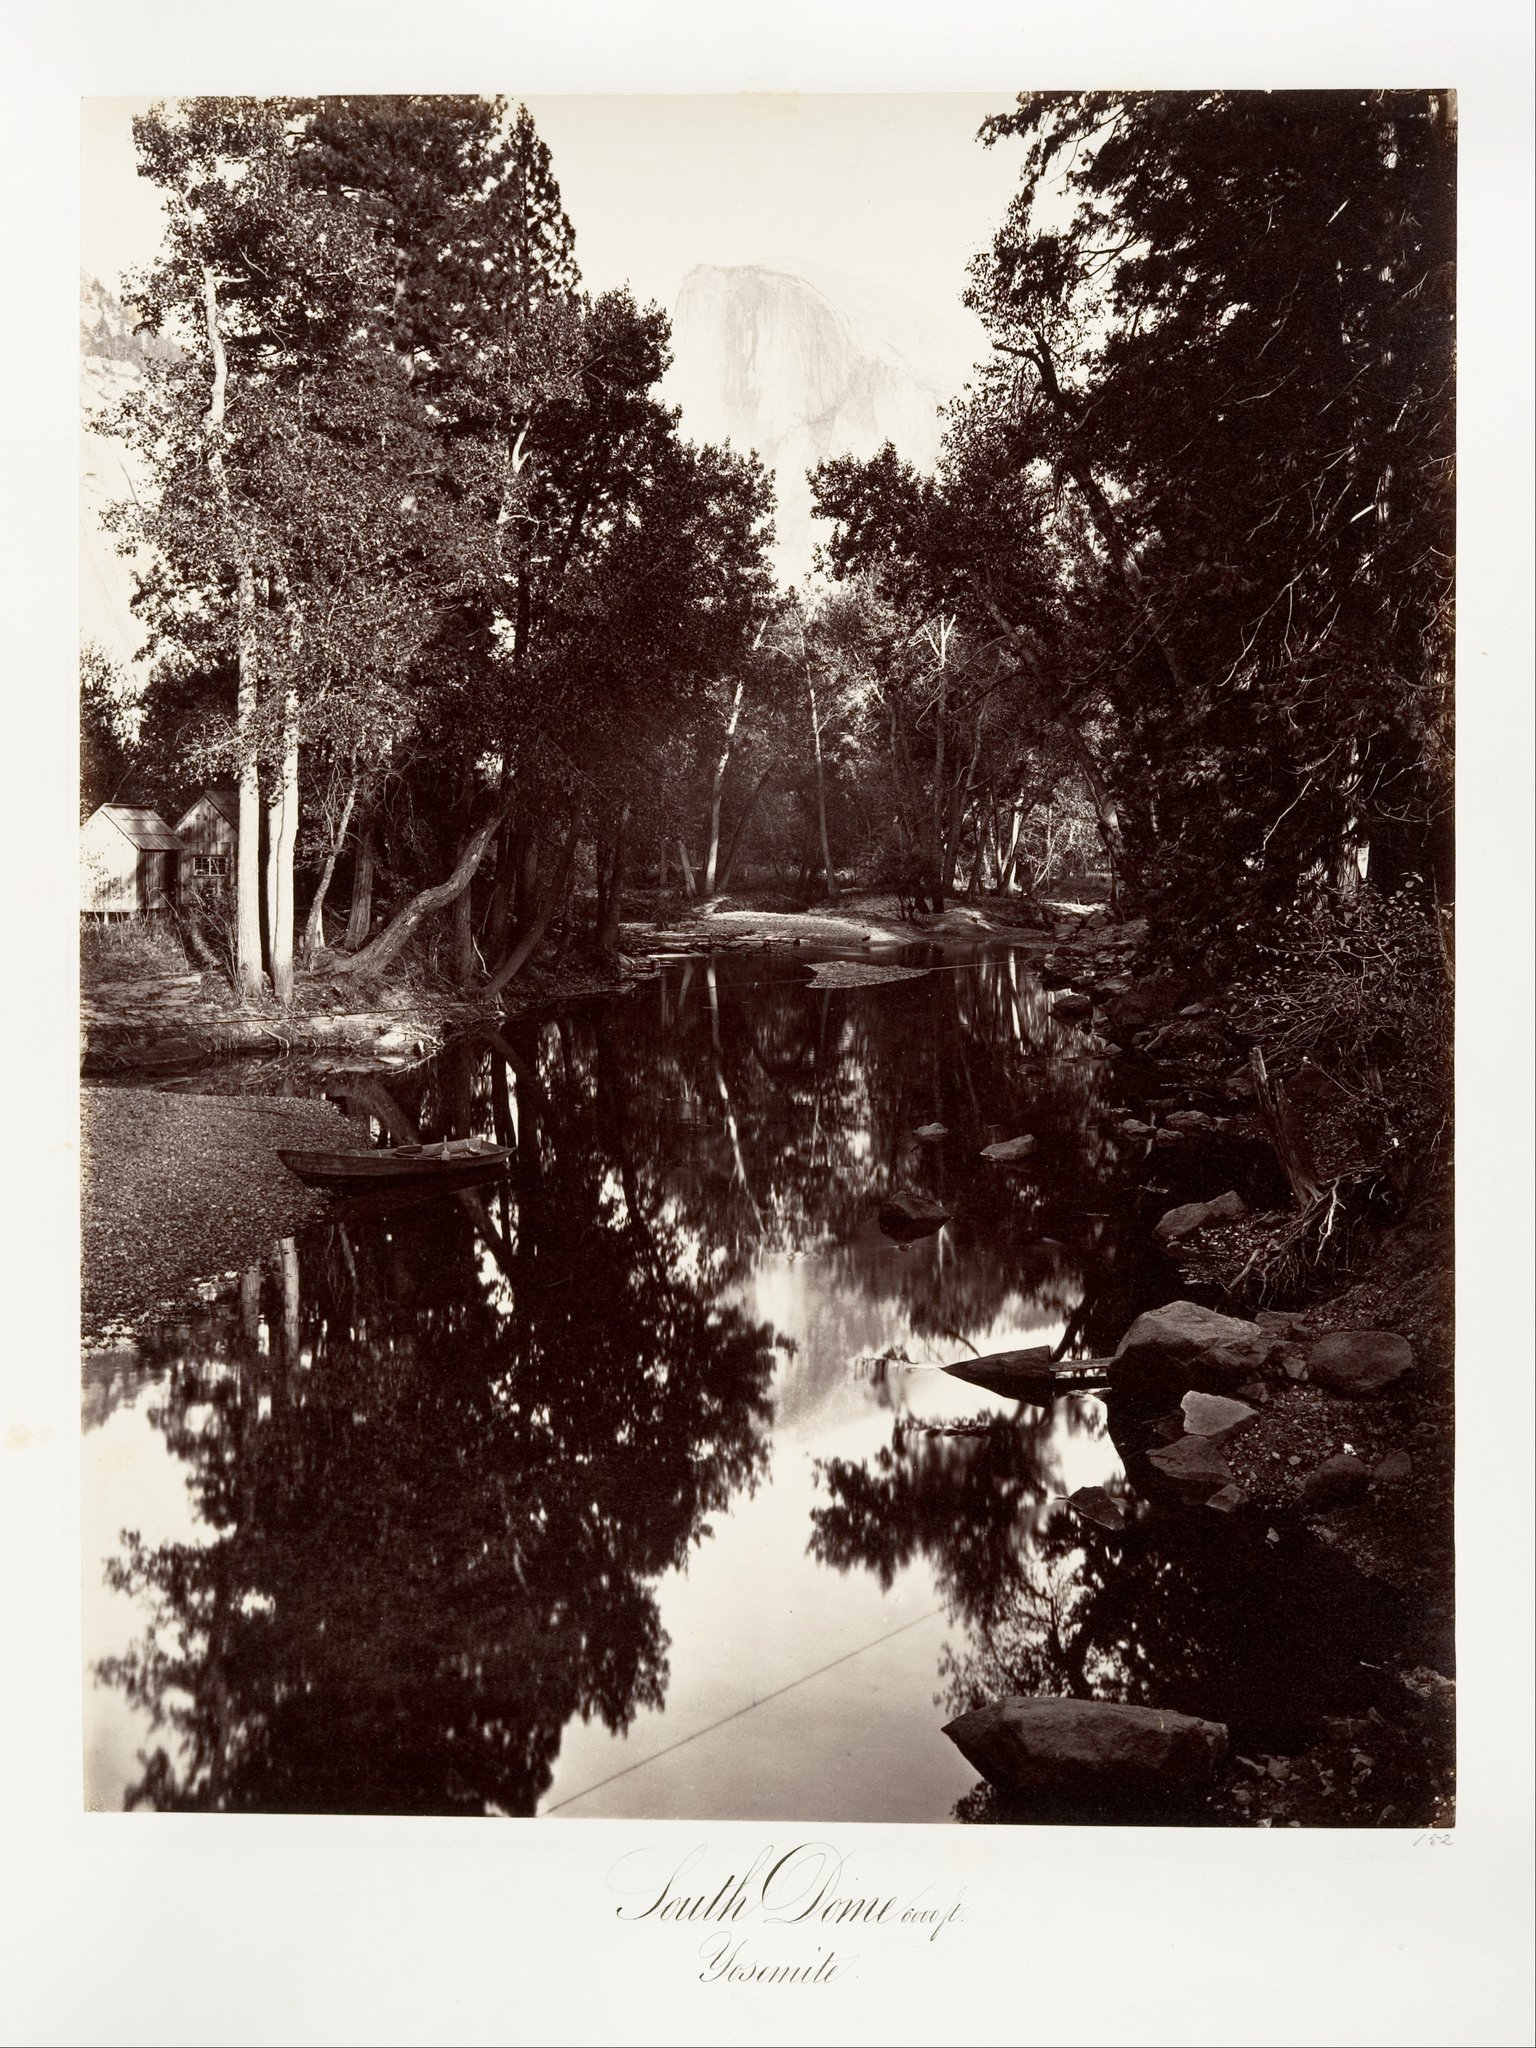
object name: photograph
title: South Dome, 6,000 feet, Yosemite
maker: carleton e. watkins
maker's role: artist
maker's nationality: american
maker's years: 1829-1916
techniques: albumen silver print, glass negative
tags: landscapes,streams